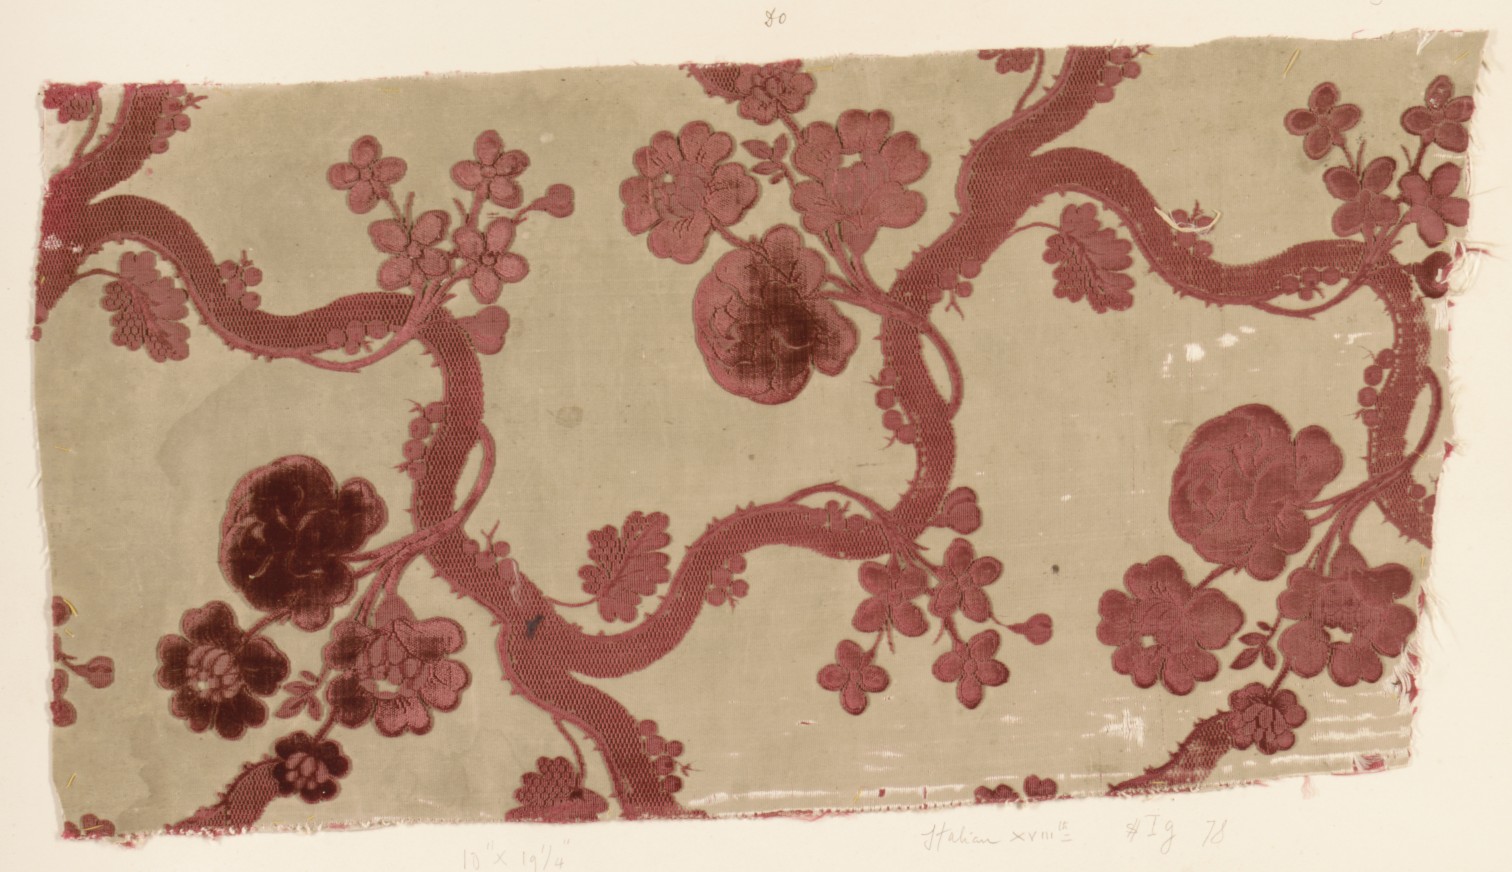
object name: fragment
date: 1701-1800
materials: silk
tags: flowers